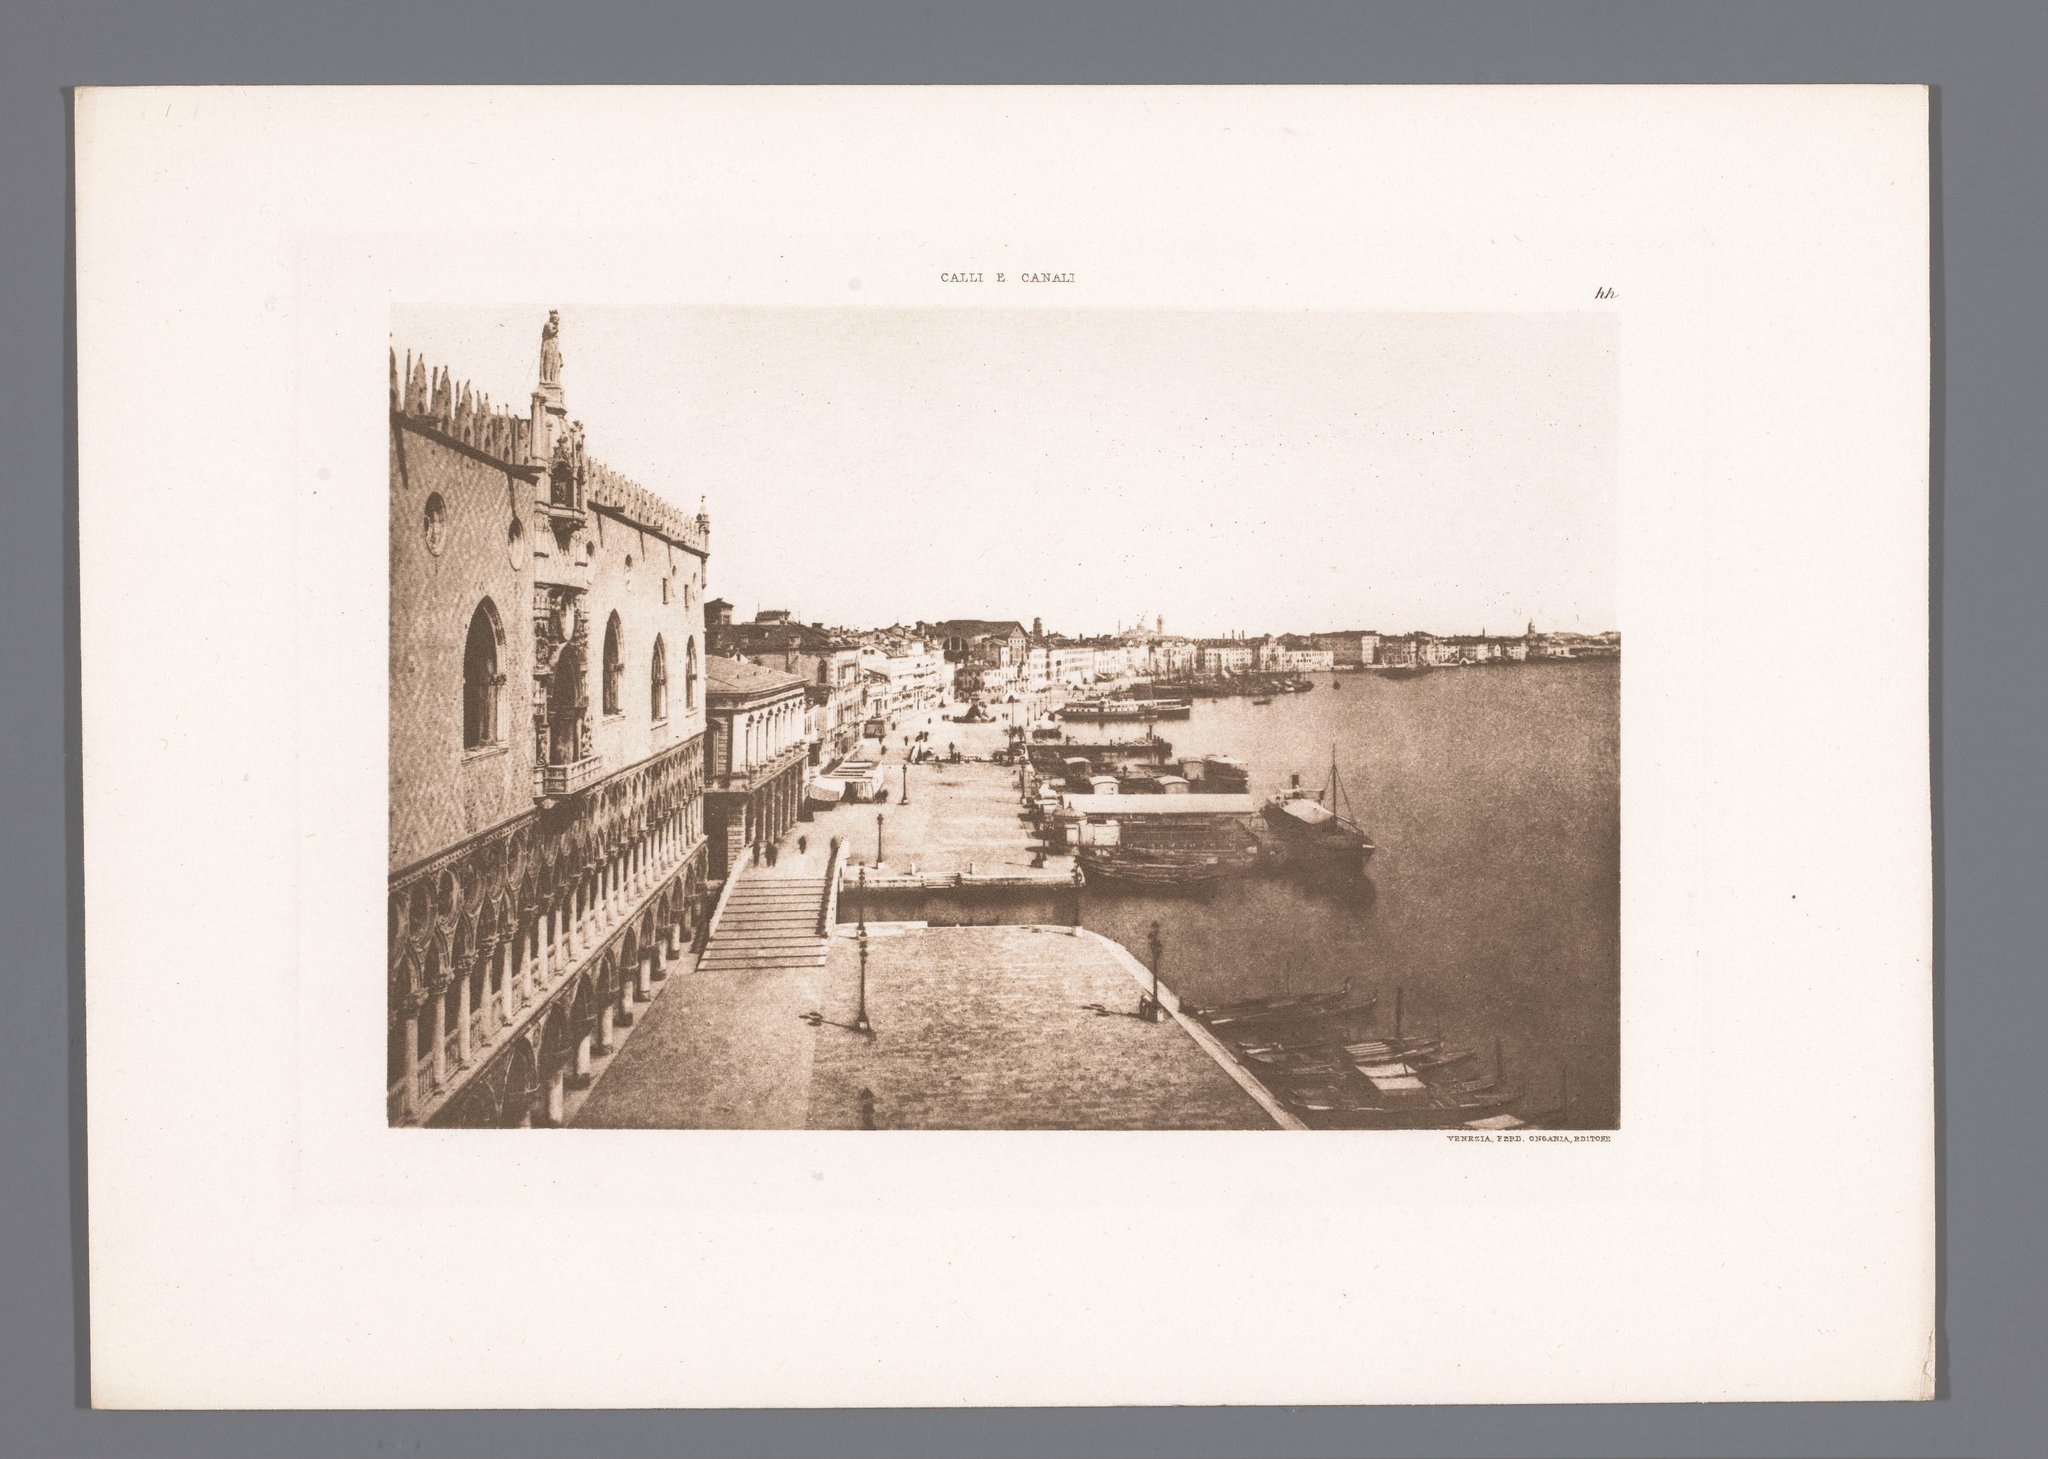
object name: page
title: Gezicht op de Riva degli Schiavoni in Venetië met het dogepaleis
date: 1888-1898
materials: paper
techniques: photoaquatint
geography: riva degli schiavoni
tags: palace, avenue, boulevard, promenade, esplanade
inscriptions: inscription: ‘hh’